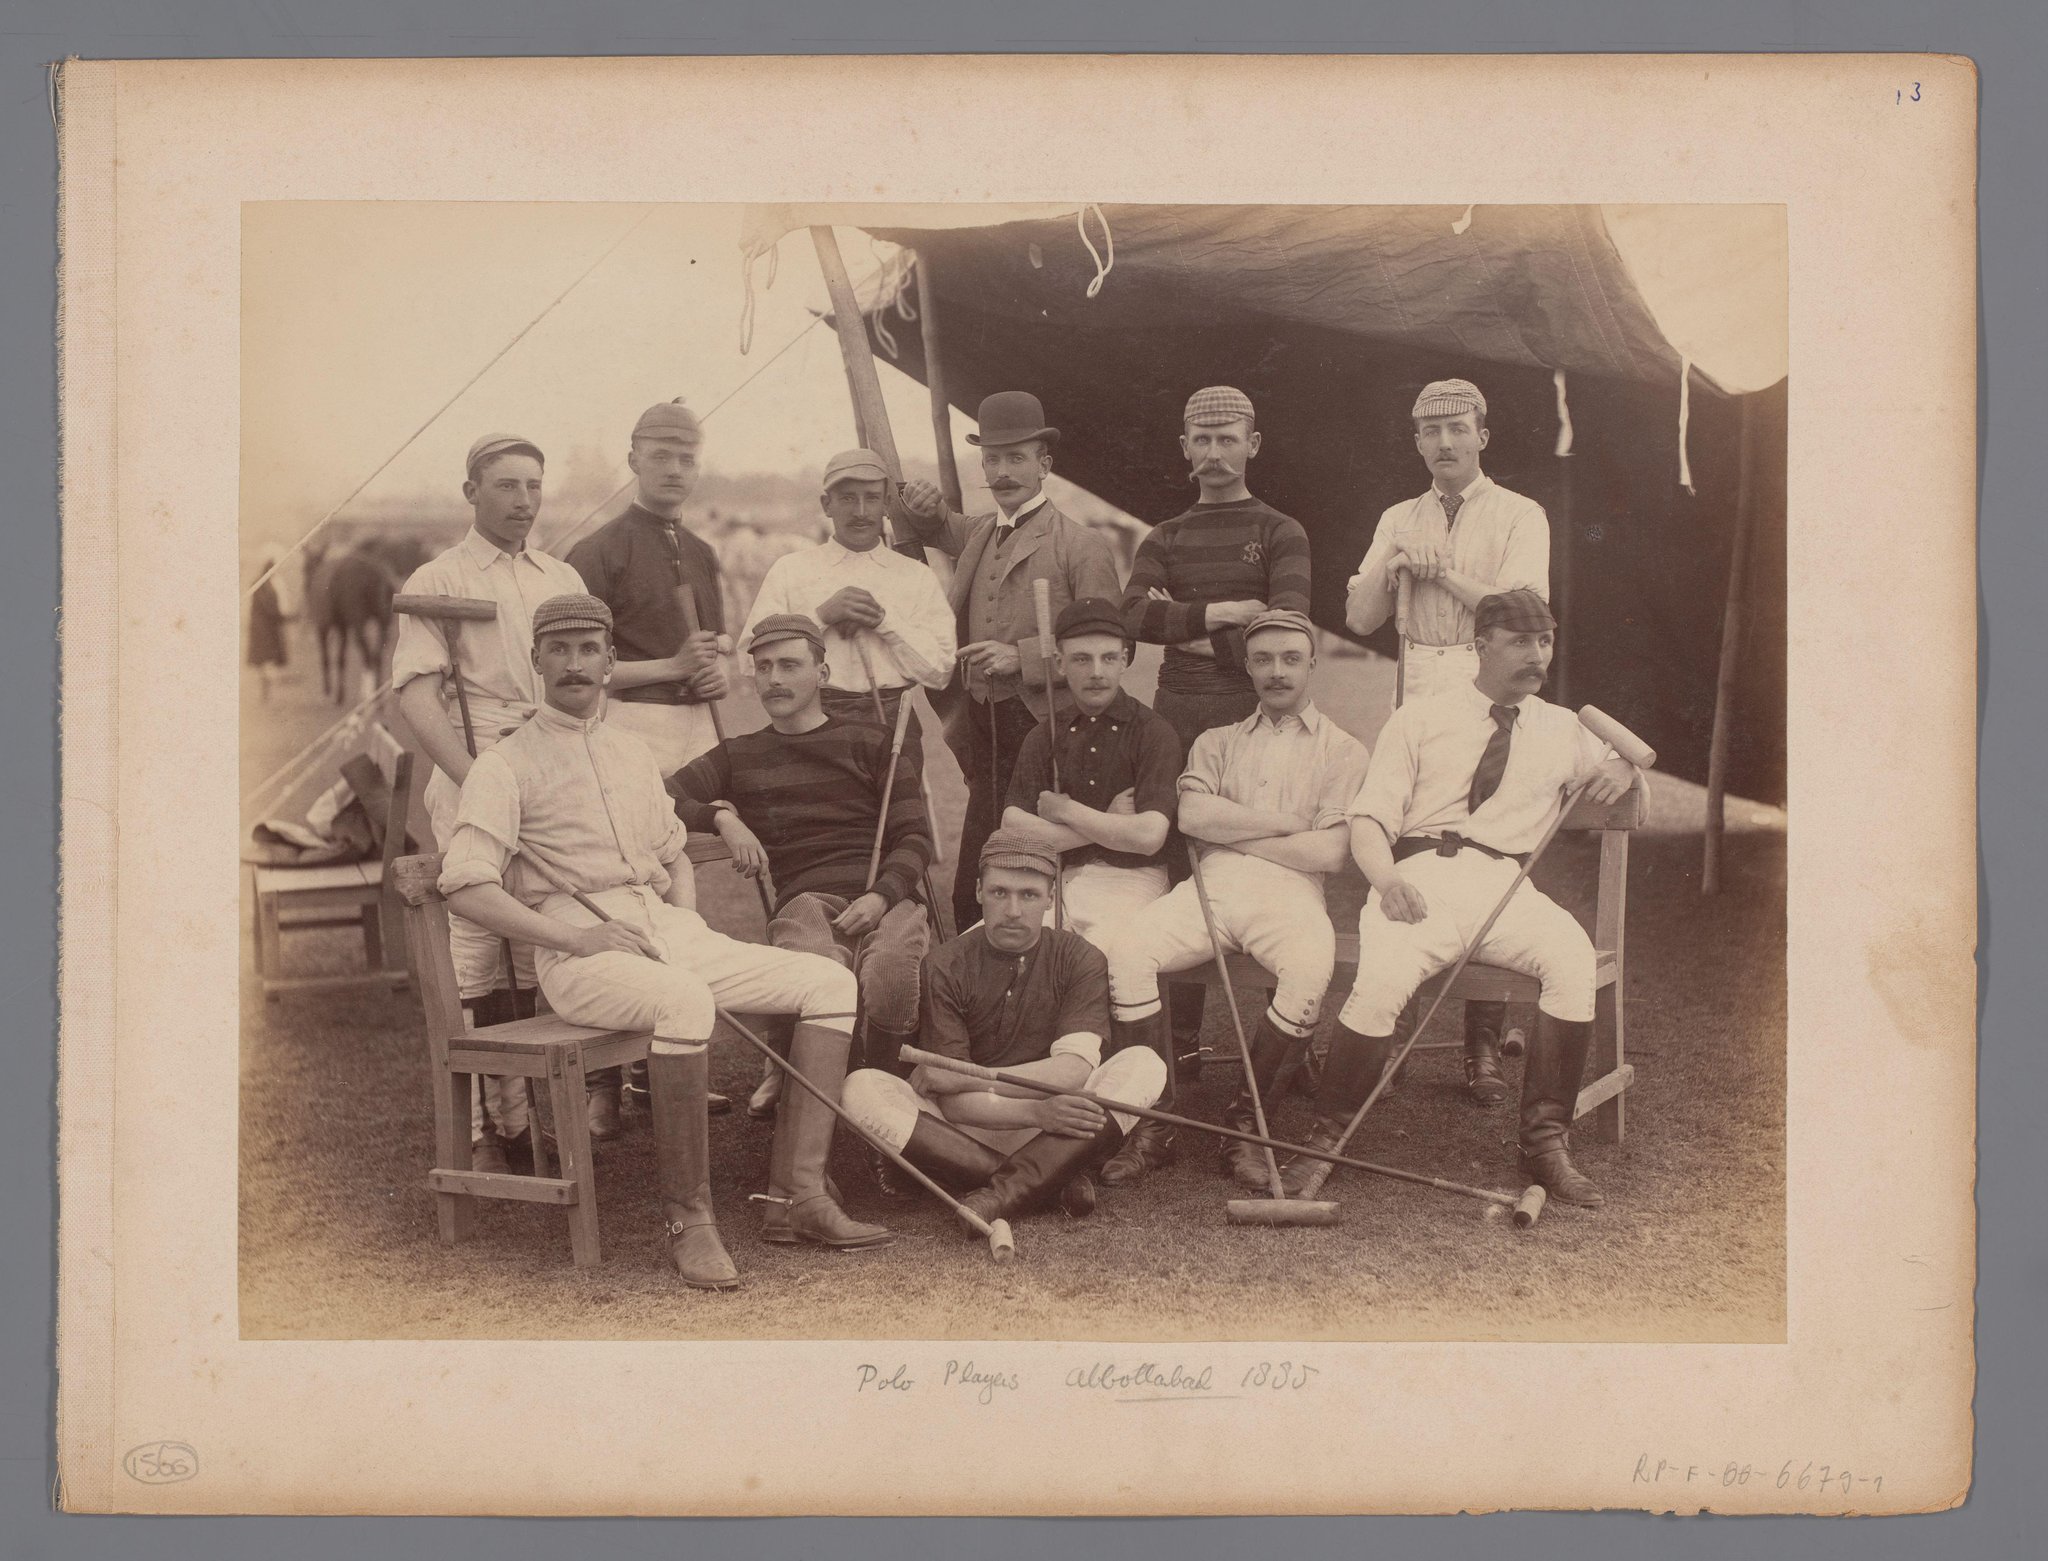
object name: photograph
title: Polo players, Abbottabad, Khyber Pakhtunkhwa, Pakistan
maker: Anonymous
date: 1885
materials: cardboard, paper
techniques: albumen print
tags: abbottabad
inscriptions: number: ‘1560’, title: ‘Polo Players Abbotlabad 1885’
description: Groepsportret van polospelers, Abbottabad, Pakistan. De mannen zitten en staan deels onder een zeil.